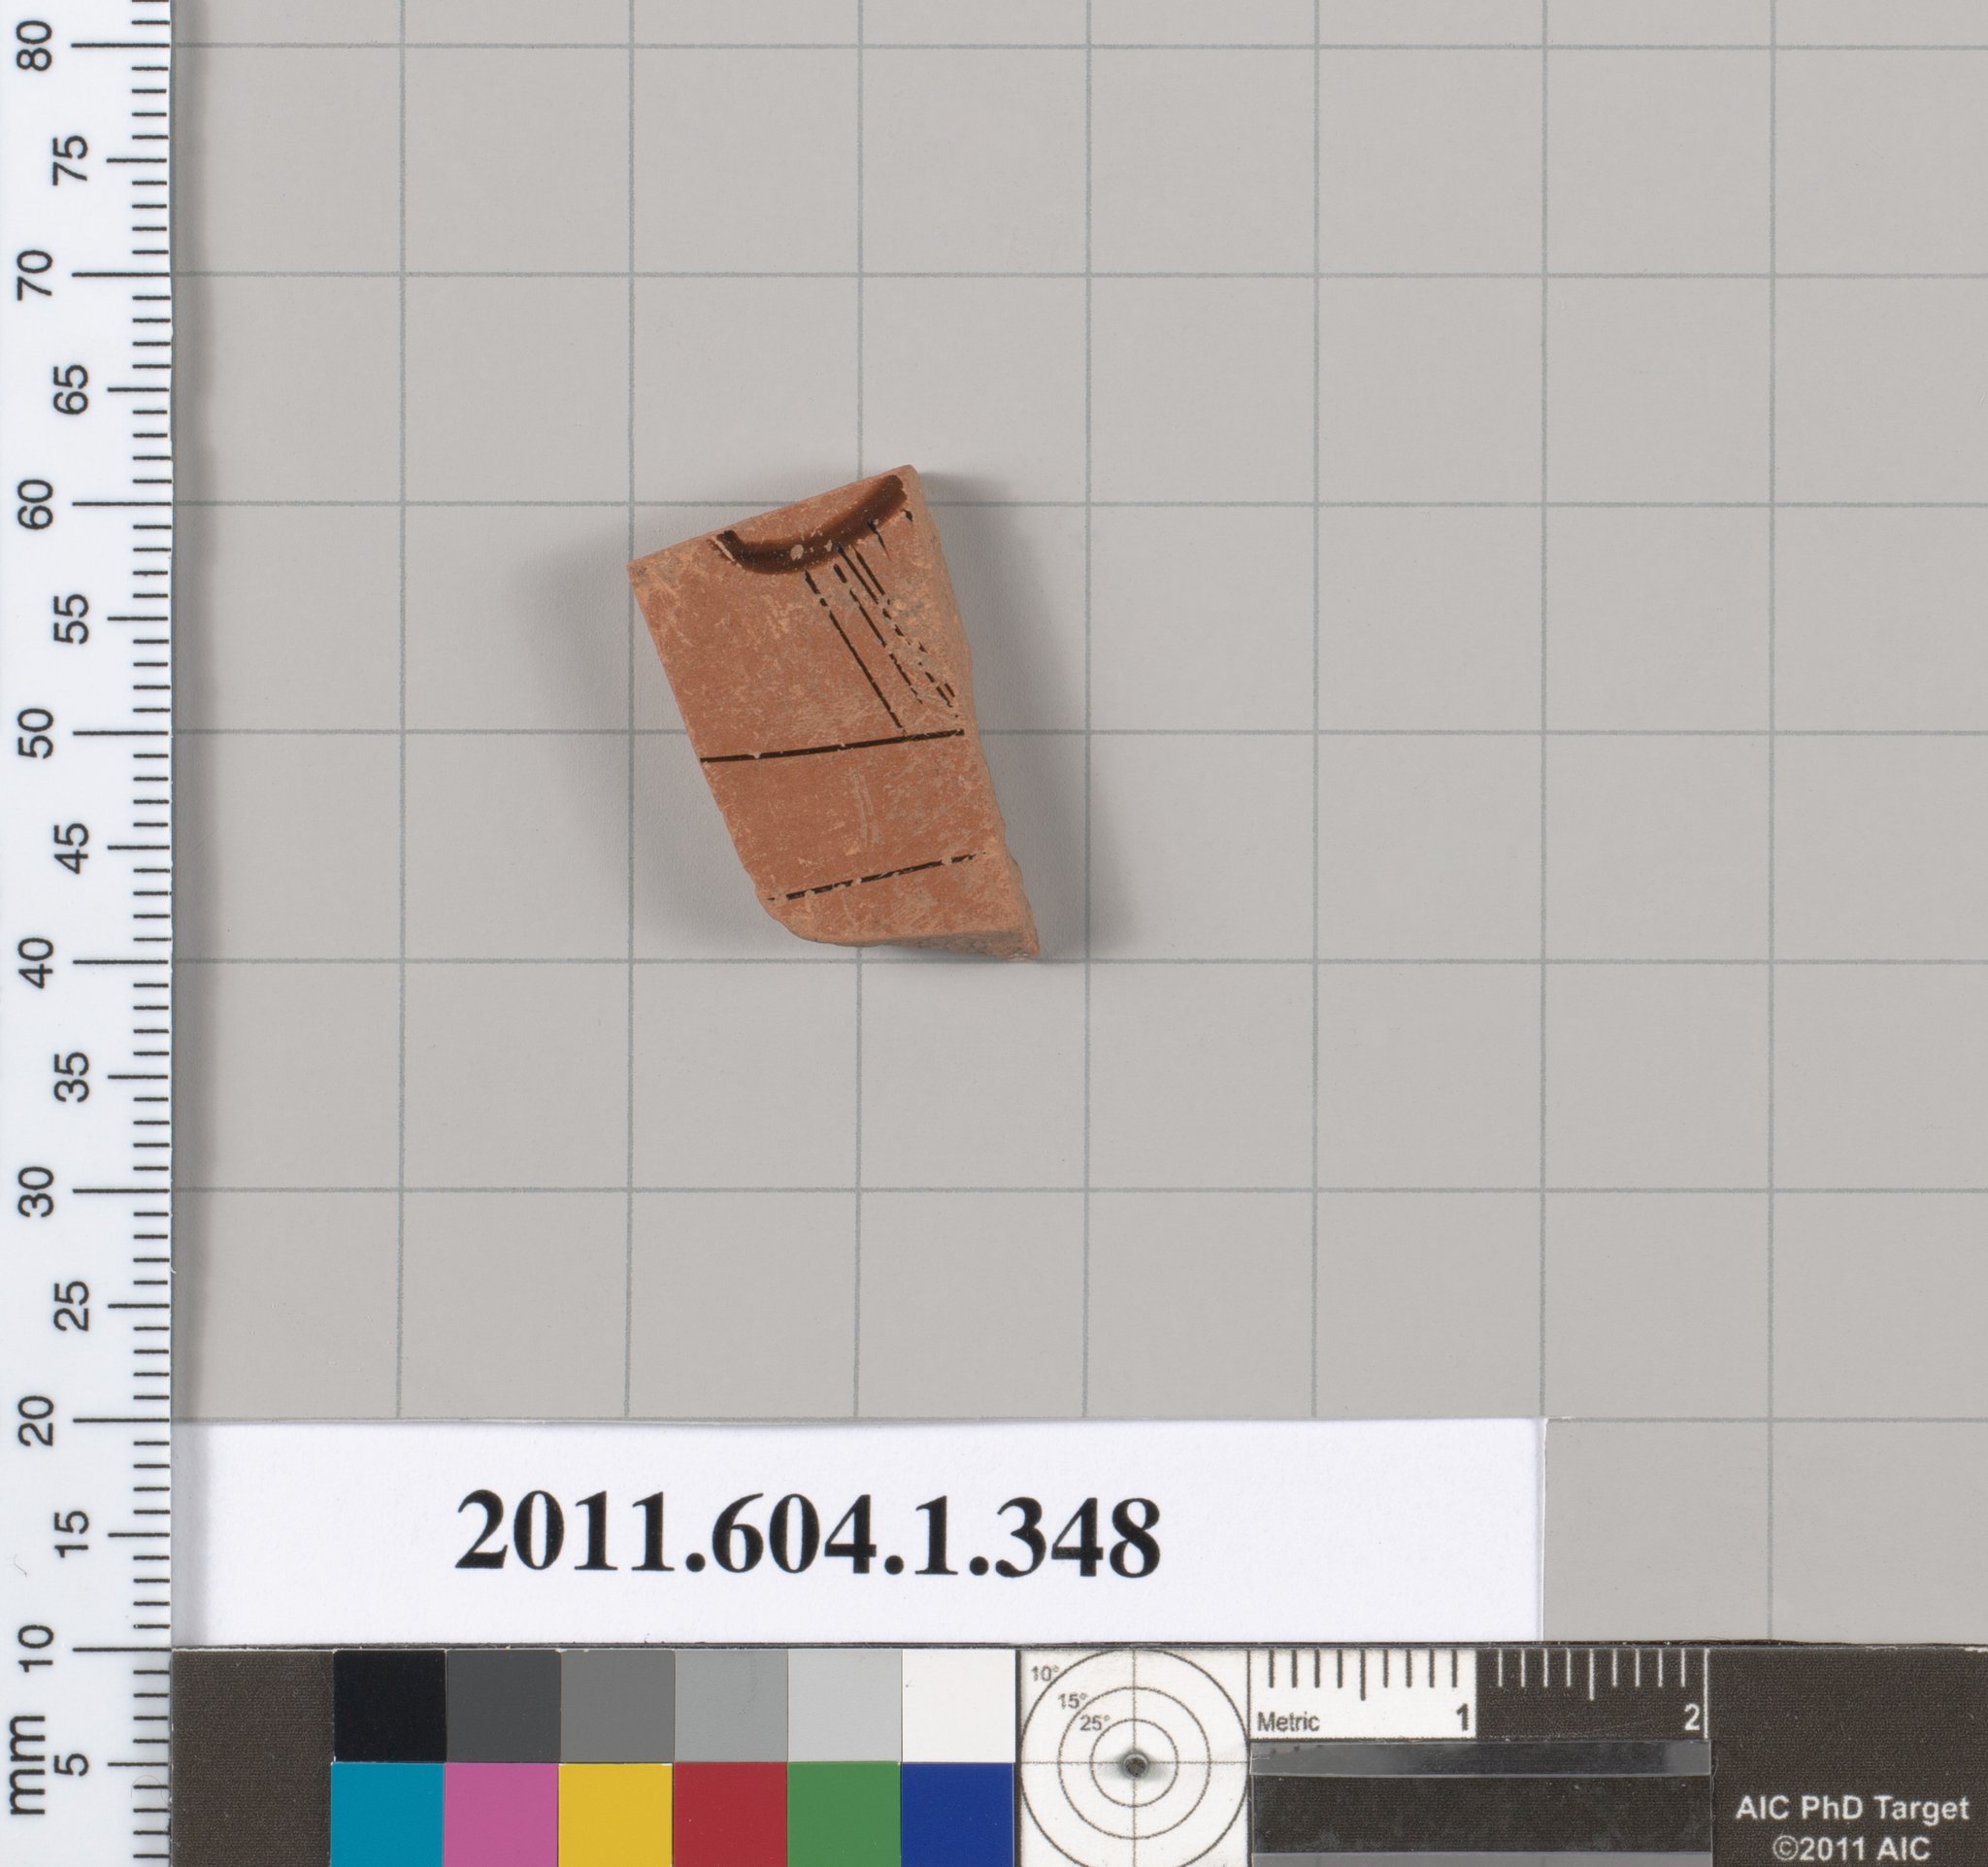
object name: kylix fragment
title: Terracotta fragment of a kylix (drinking cup)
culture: greek, attic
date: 475-451 BCE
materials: terracotta